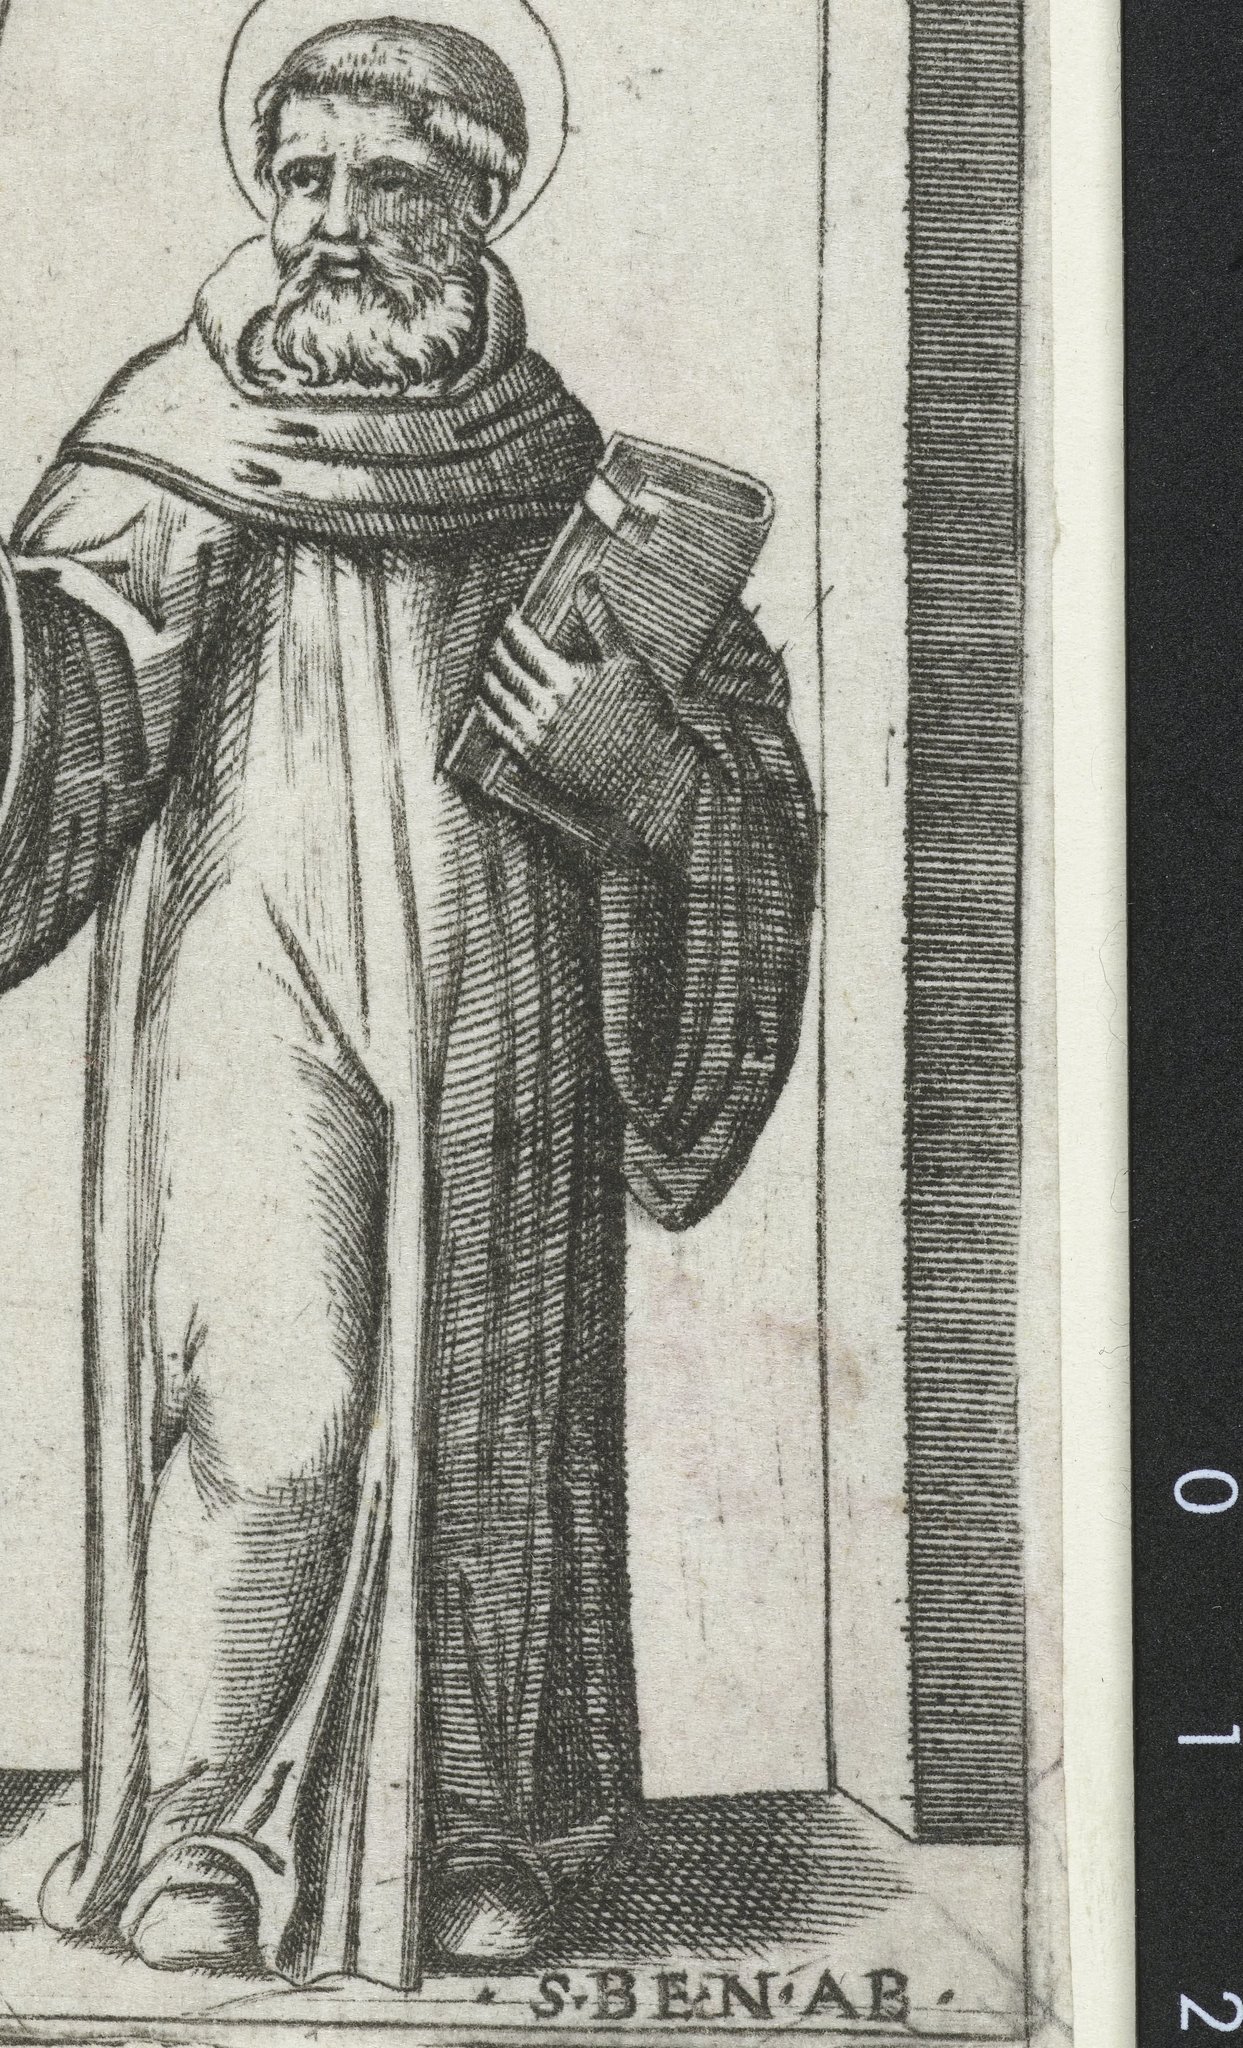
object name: print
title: Heilige Benno met kromstaf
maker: Anonymous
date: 1500-1575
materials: paper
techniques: engraving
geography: italy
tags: male saints (with name)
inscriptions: collector's mark: Lugt 12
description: Kopie naar prent van Marcantonio Raimondi.